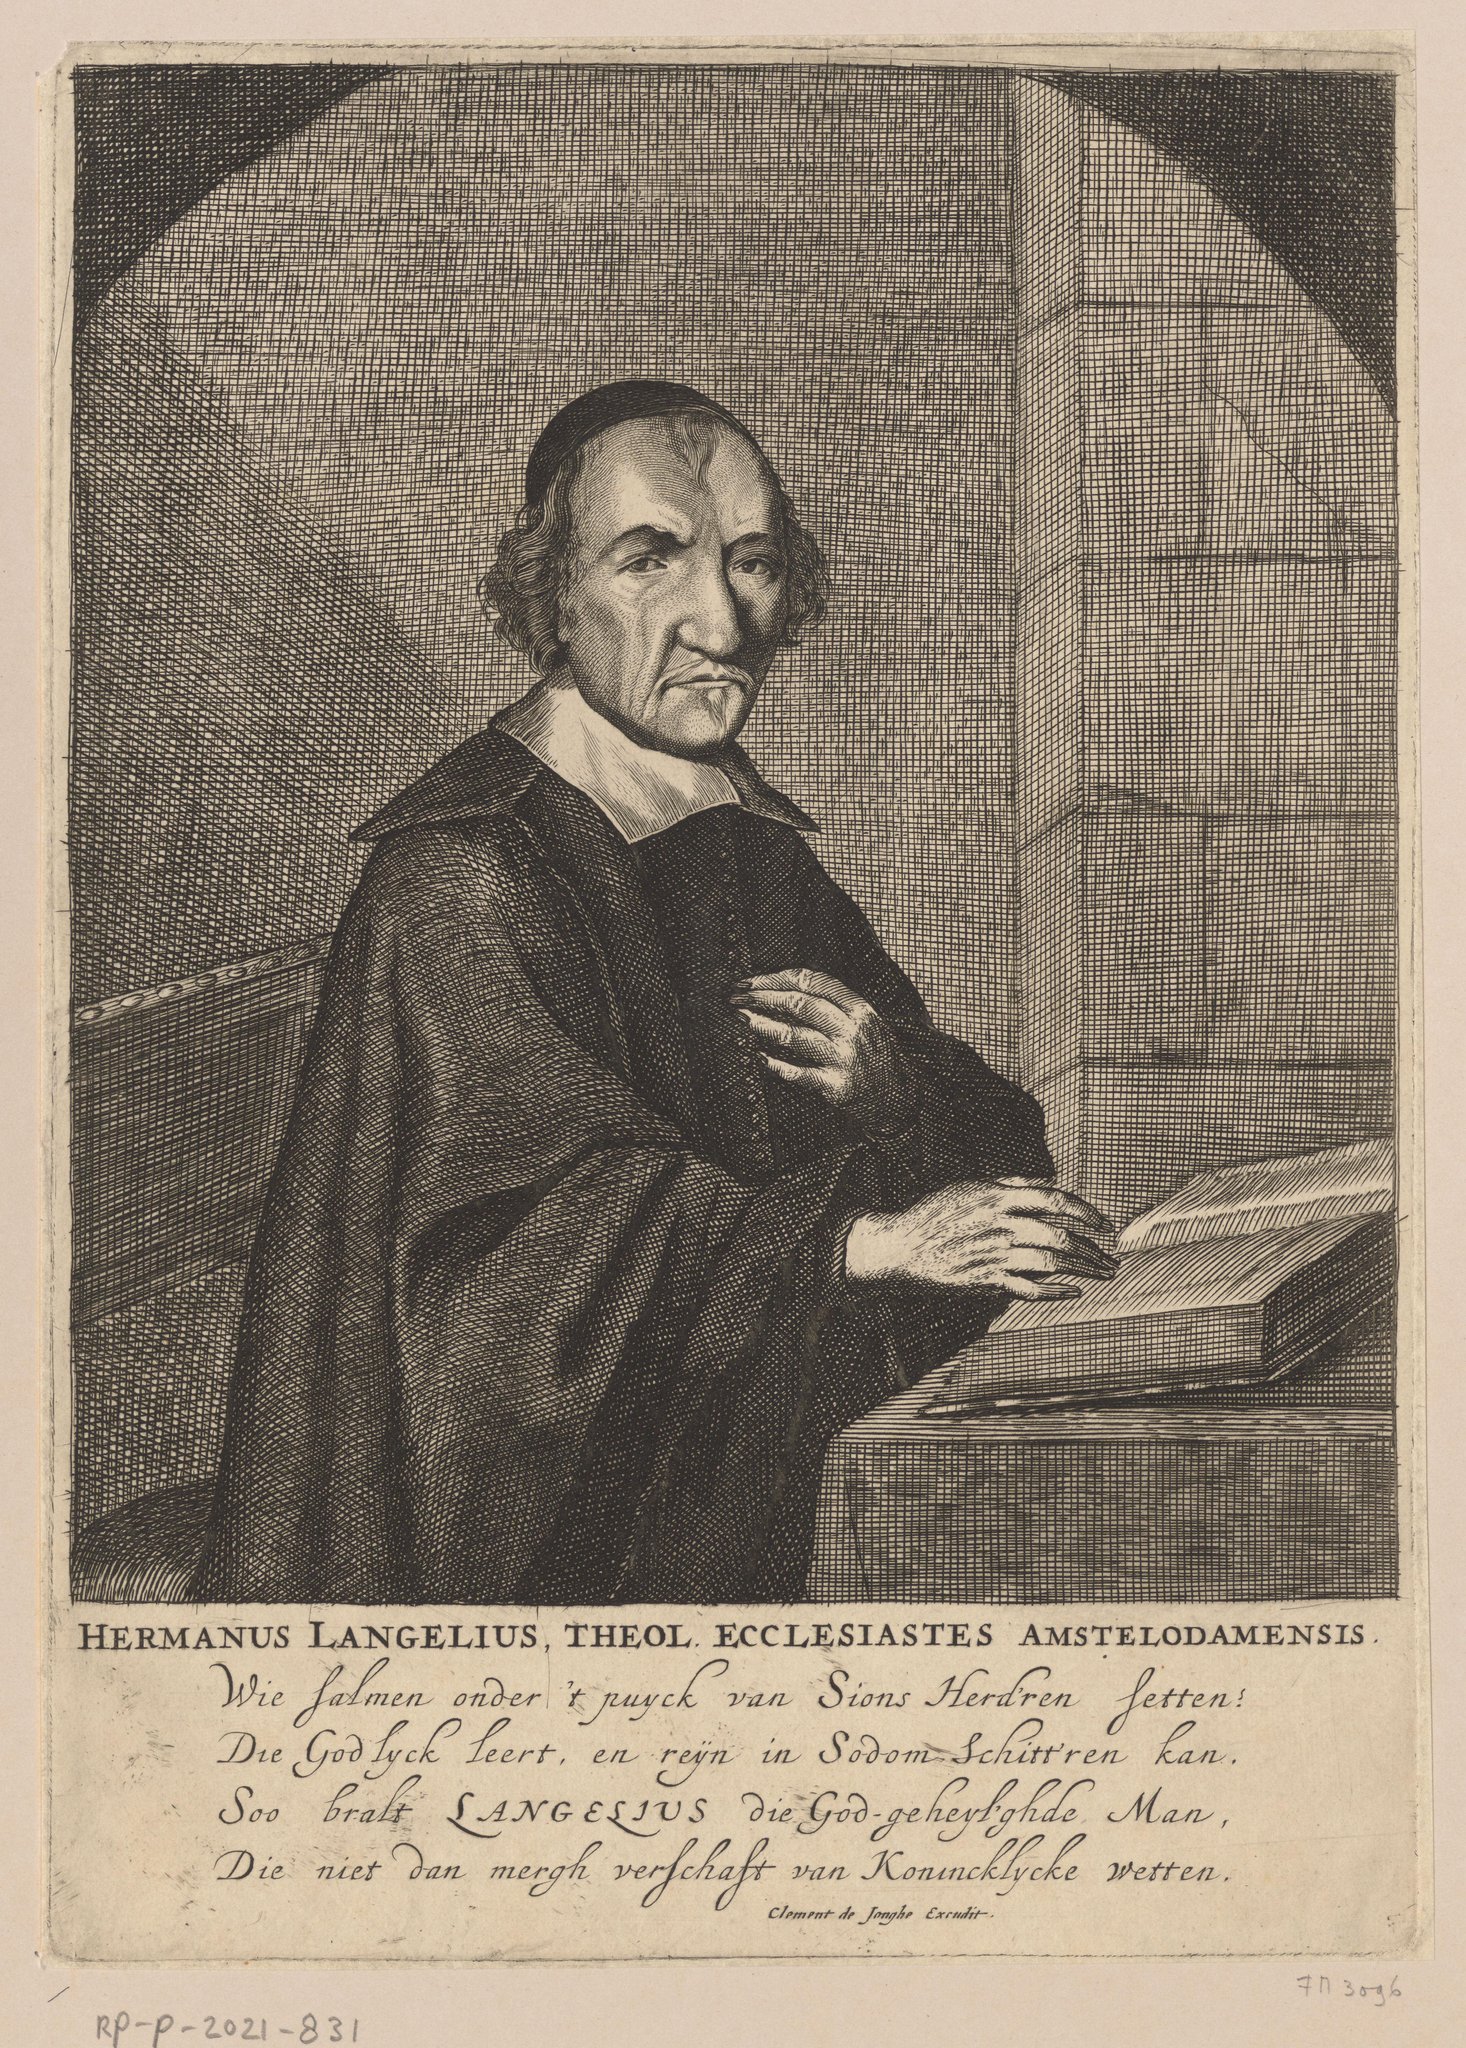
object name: print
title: Portret van Hermanus Langelius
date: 1655-1677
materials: paper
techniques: engraving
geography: amsterdam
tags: historical persons, book - mm - book open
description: Met vierregelig Nederlands vers onder het portret.